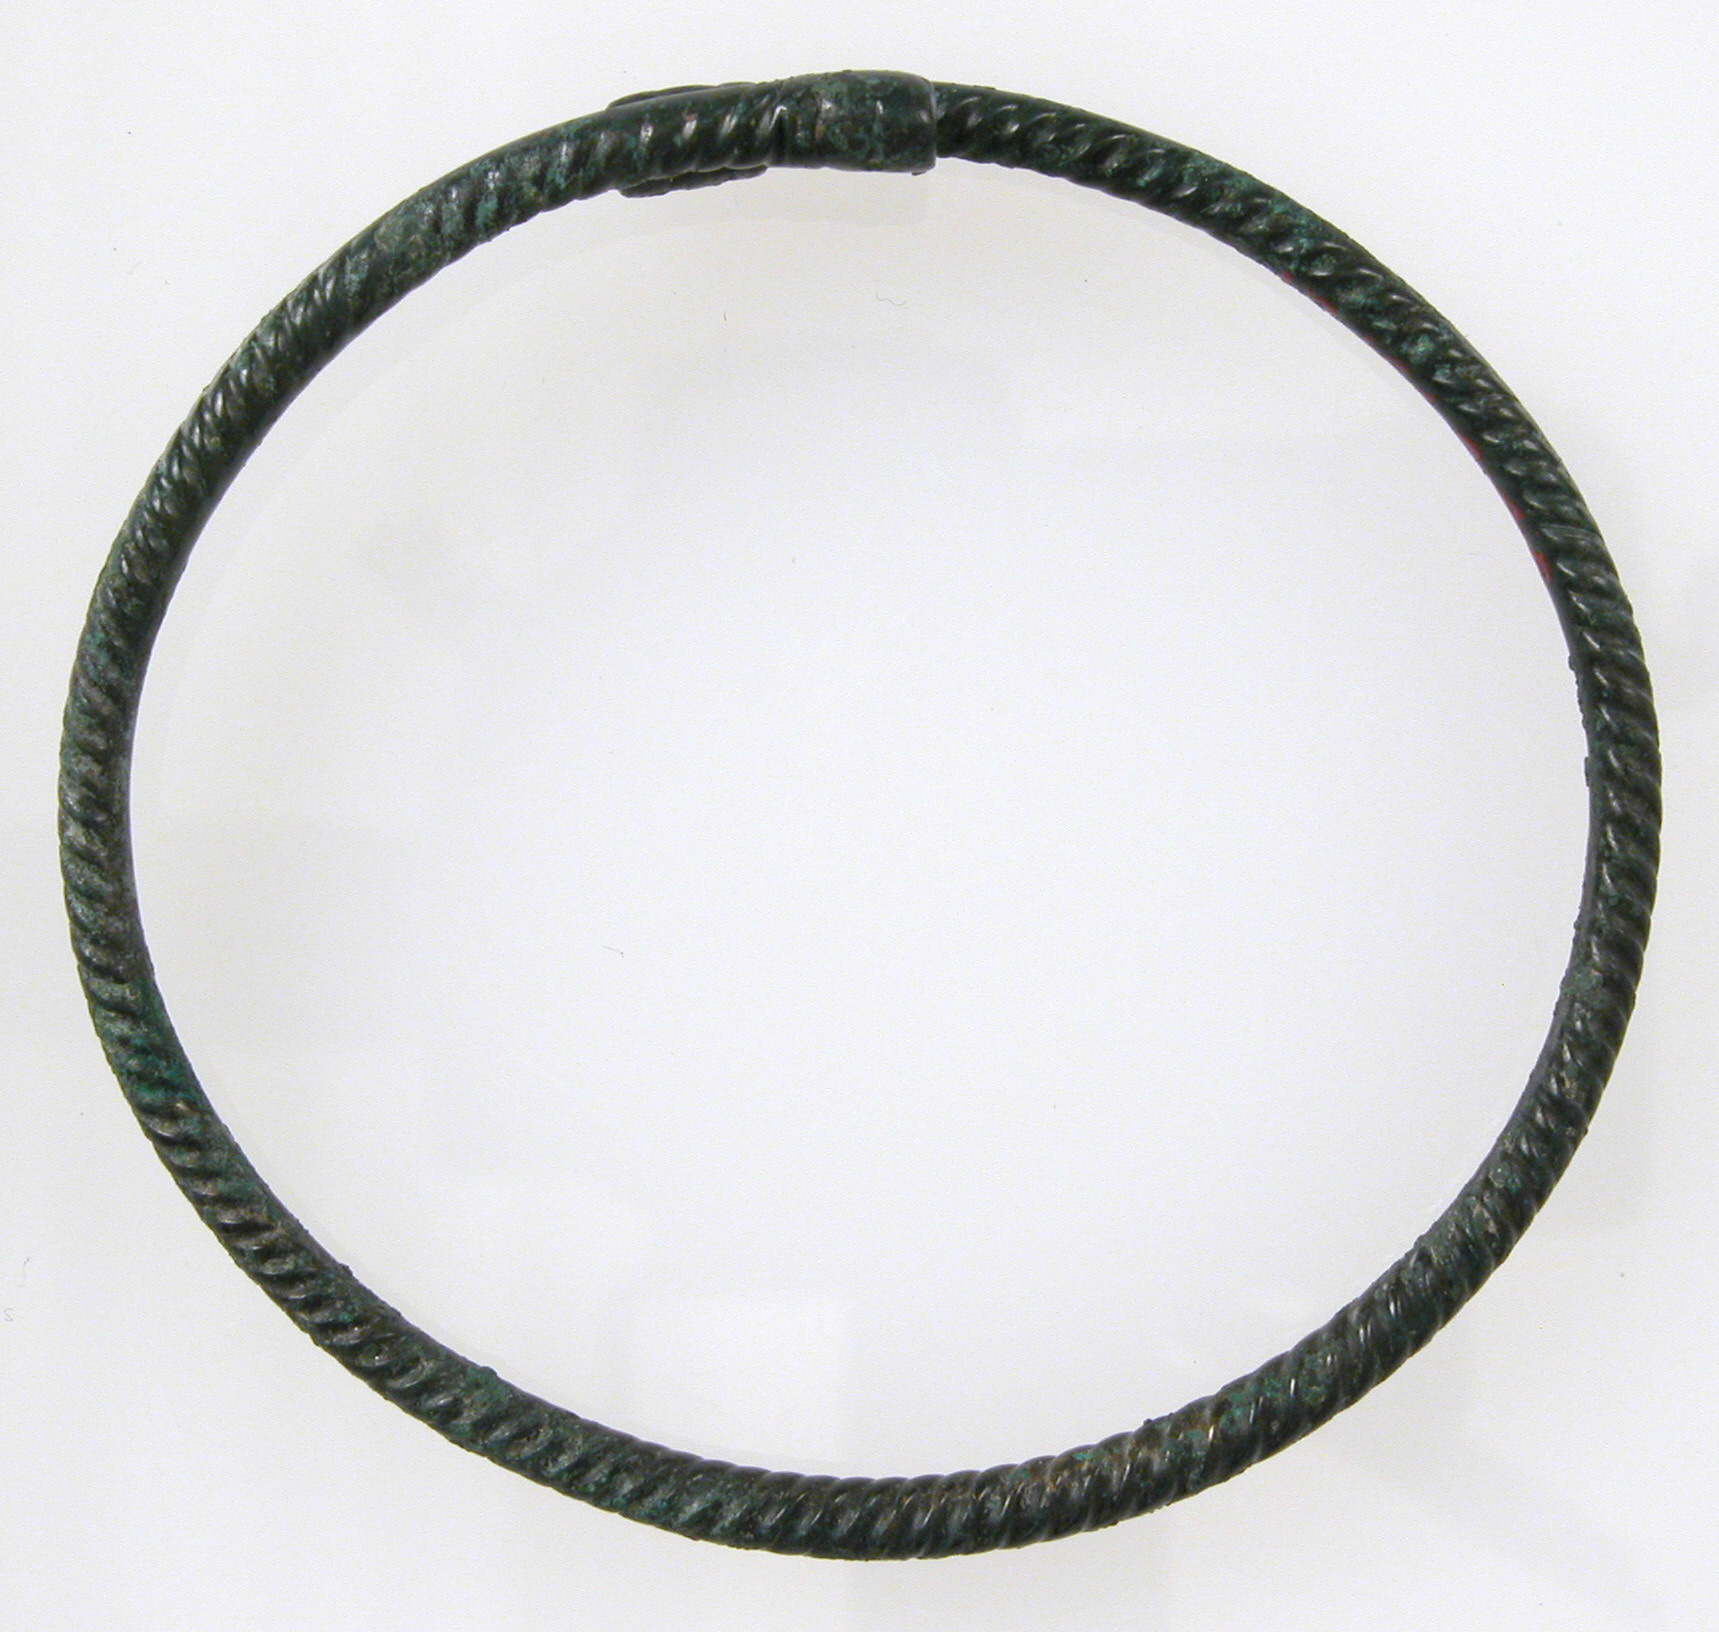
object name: bracelet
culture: celtic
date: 401-500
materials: copper alloy